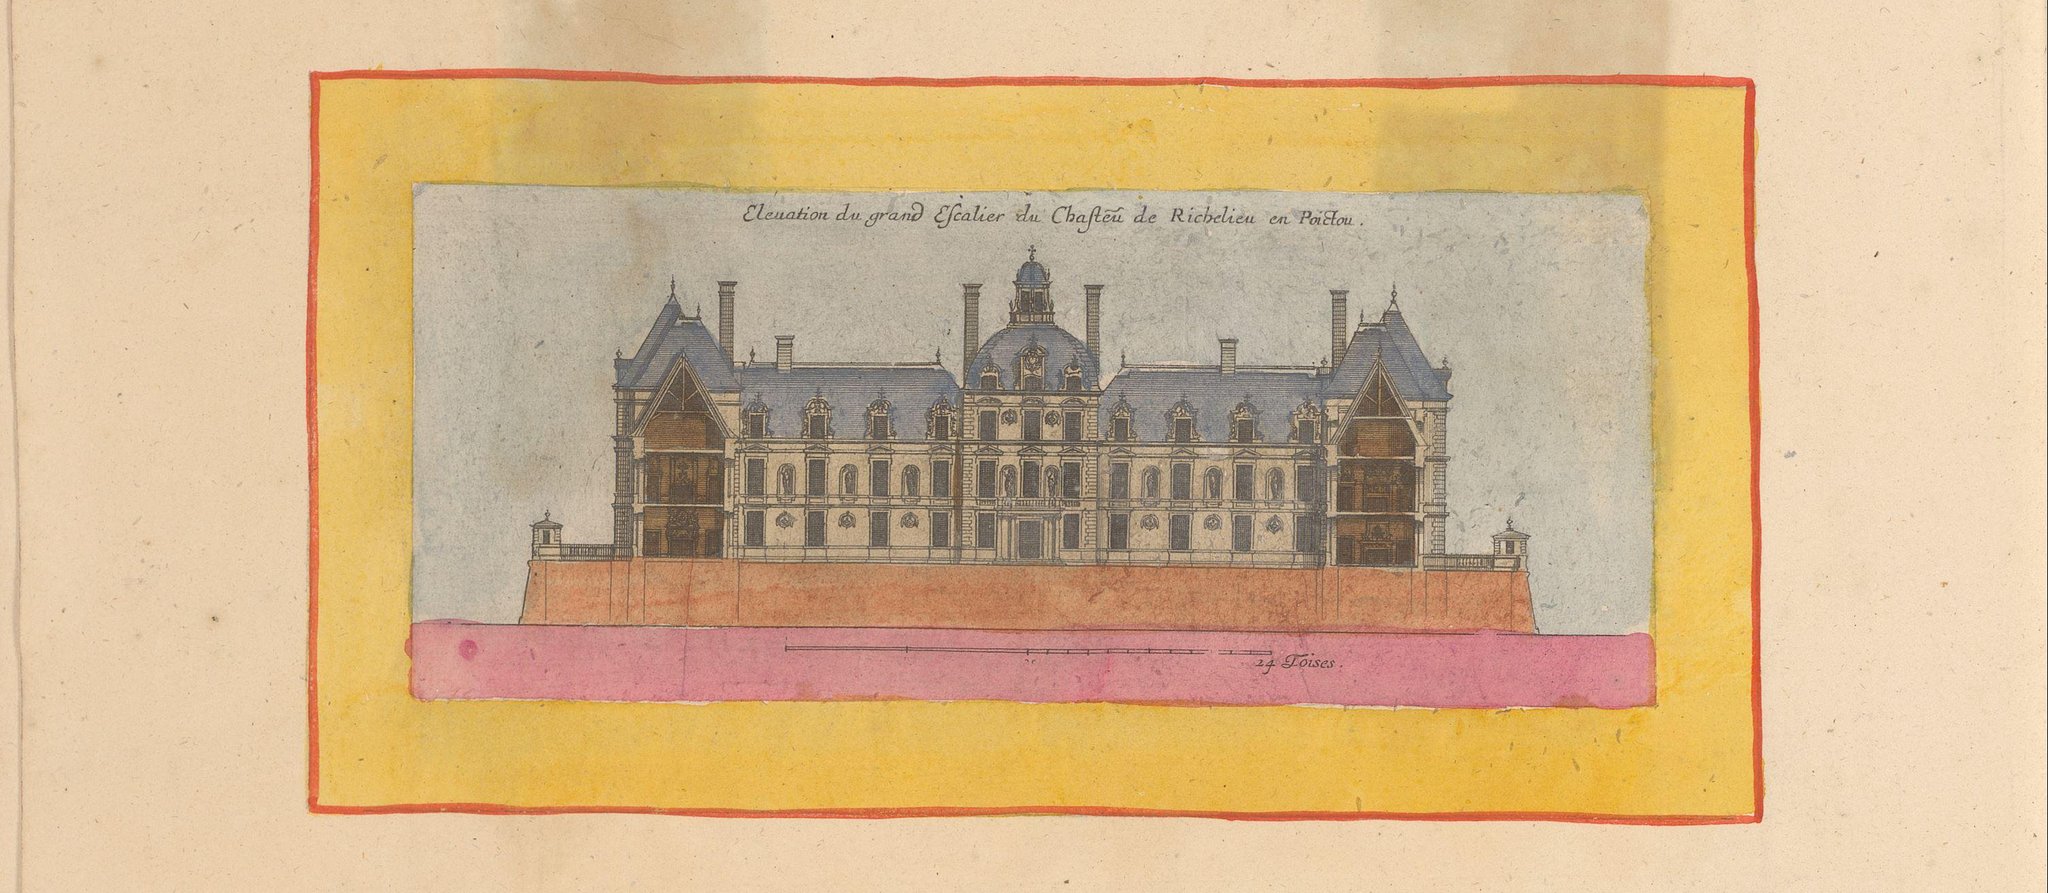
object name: print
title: Le magnifique chasteau de Richelieu, ou les plans, les fassades, les elevations et profils du dit chasteau (...)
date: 1629-1679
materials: paper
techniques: etching, hand coloring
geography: the hague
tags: castle, series of designs, models, etc. of one architectural project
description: Deze prent maakt deel uit van een album.